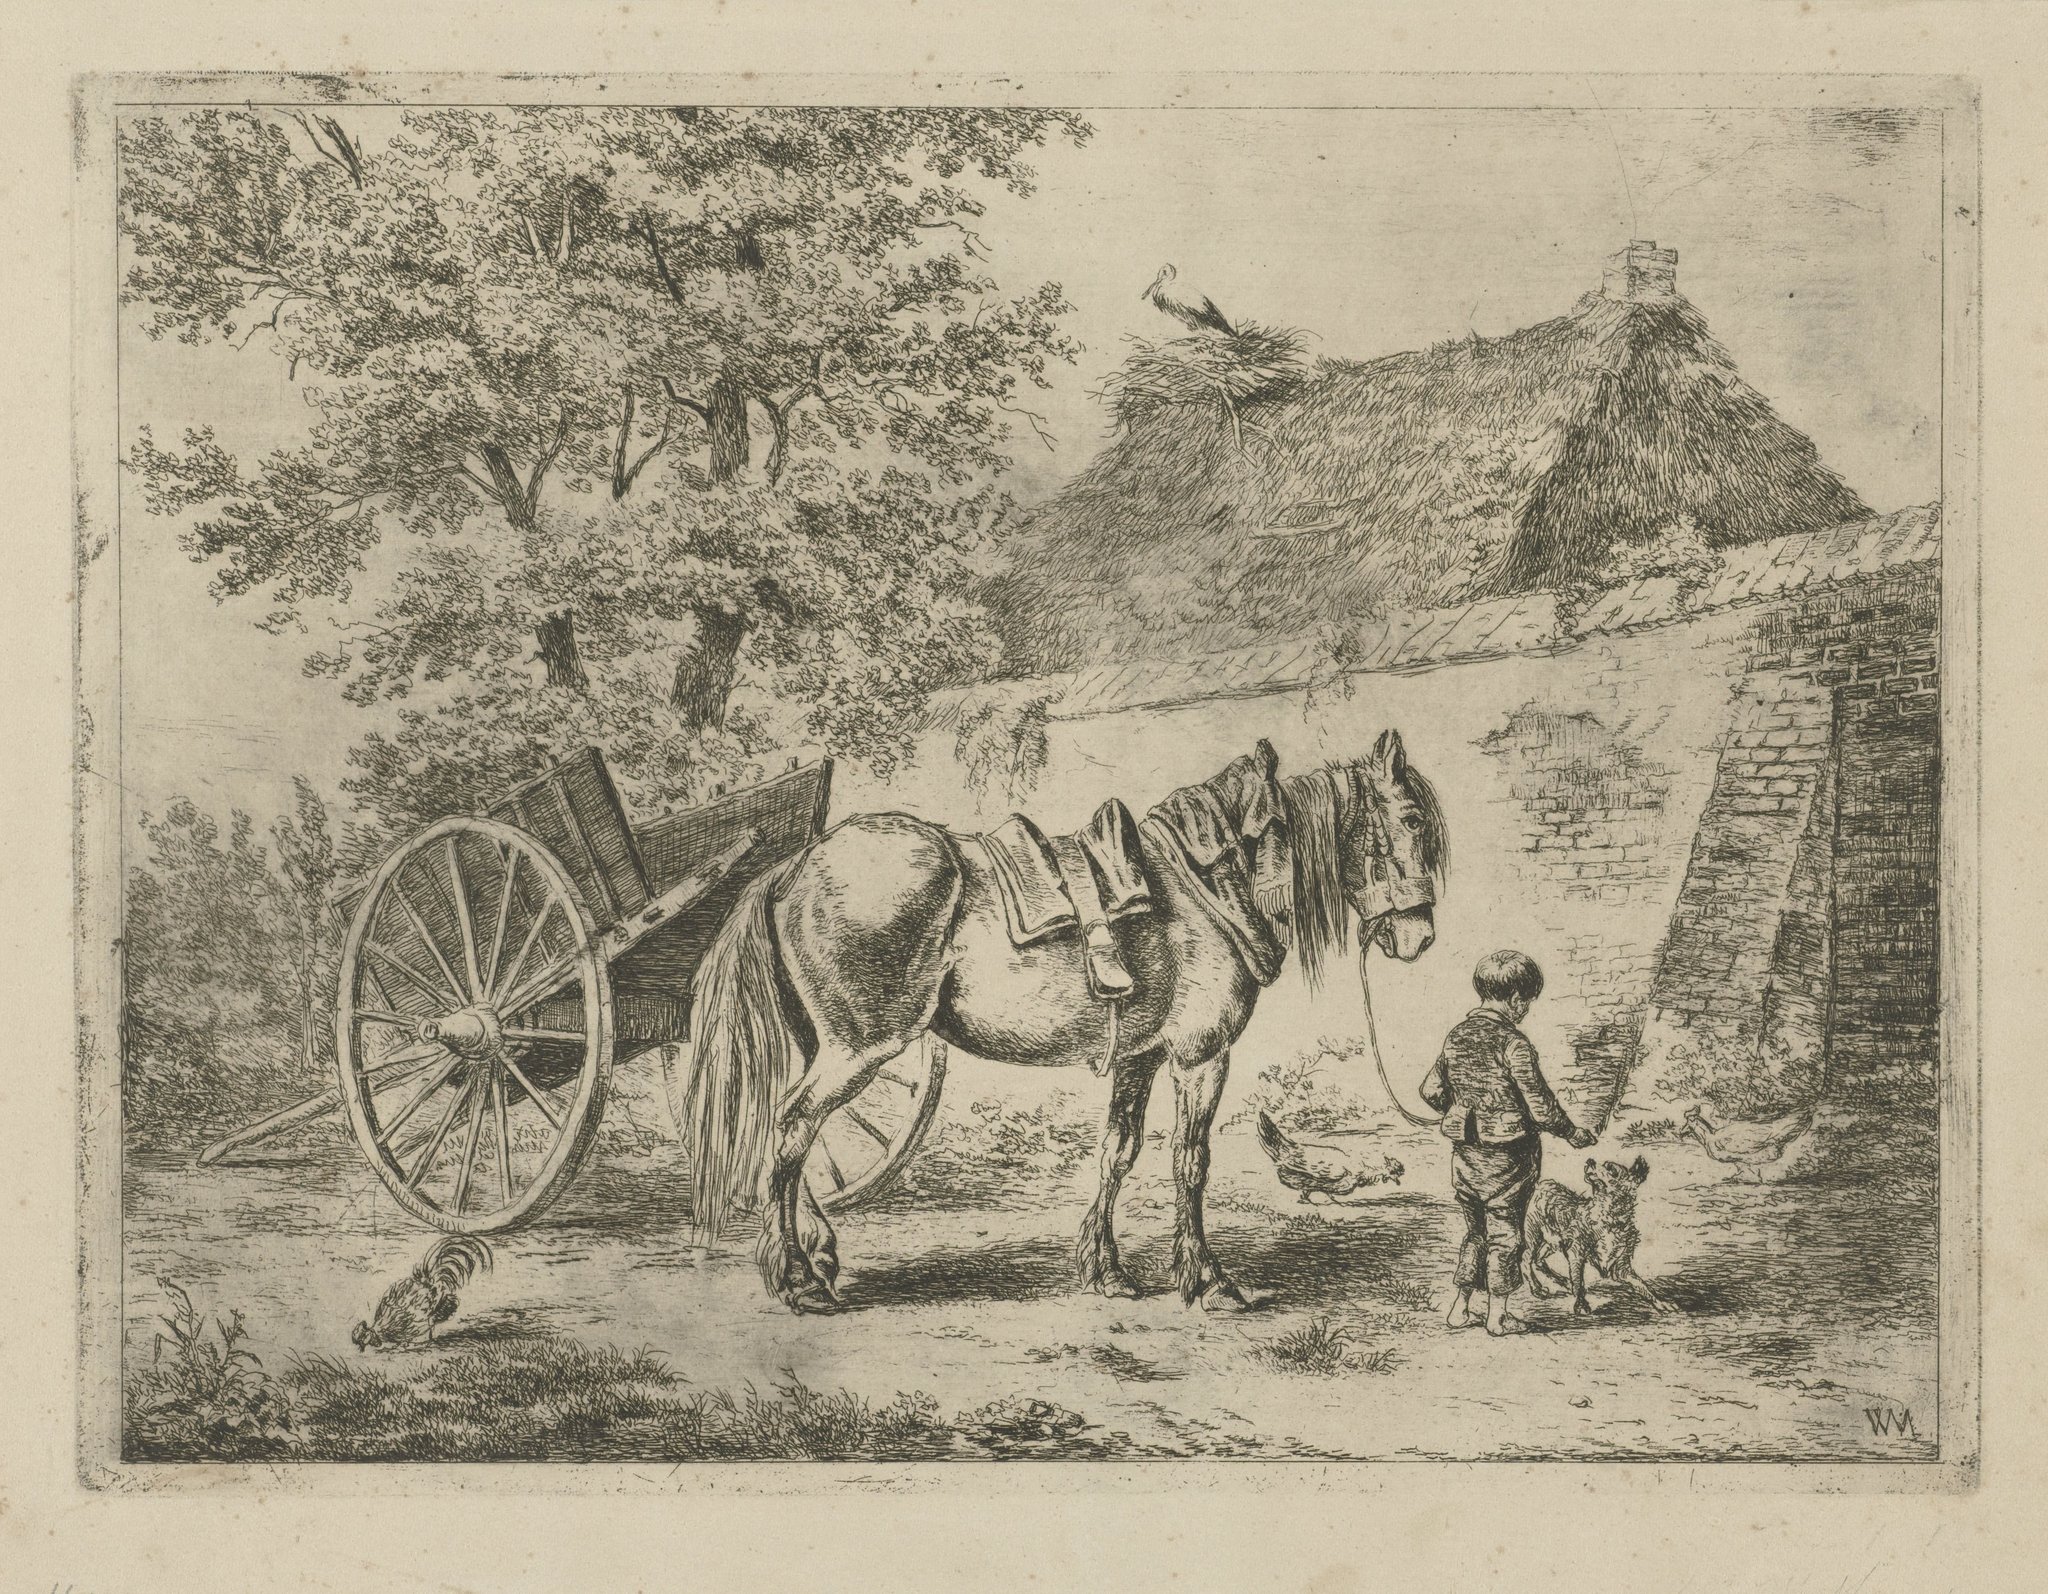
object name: print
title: Jongen met een paard en hond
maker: christiaan wilhelmus moorrees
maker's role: draughtsman, print maker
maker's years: 1801-1867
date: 1811-1867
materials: paper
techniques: etching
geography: netherlands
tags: shore-birds and wading-birds: stork, boy (child between toddler and youth), horse, dog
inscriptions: collector's mark: Lugt 2228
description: Een jongen met een paard aan de teugel speelt met een hond. Op het dak van het huis achter de muur een ooievaarsnest.